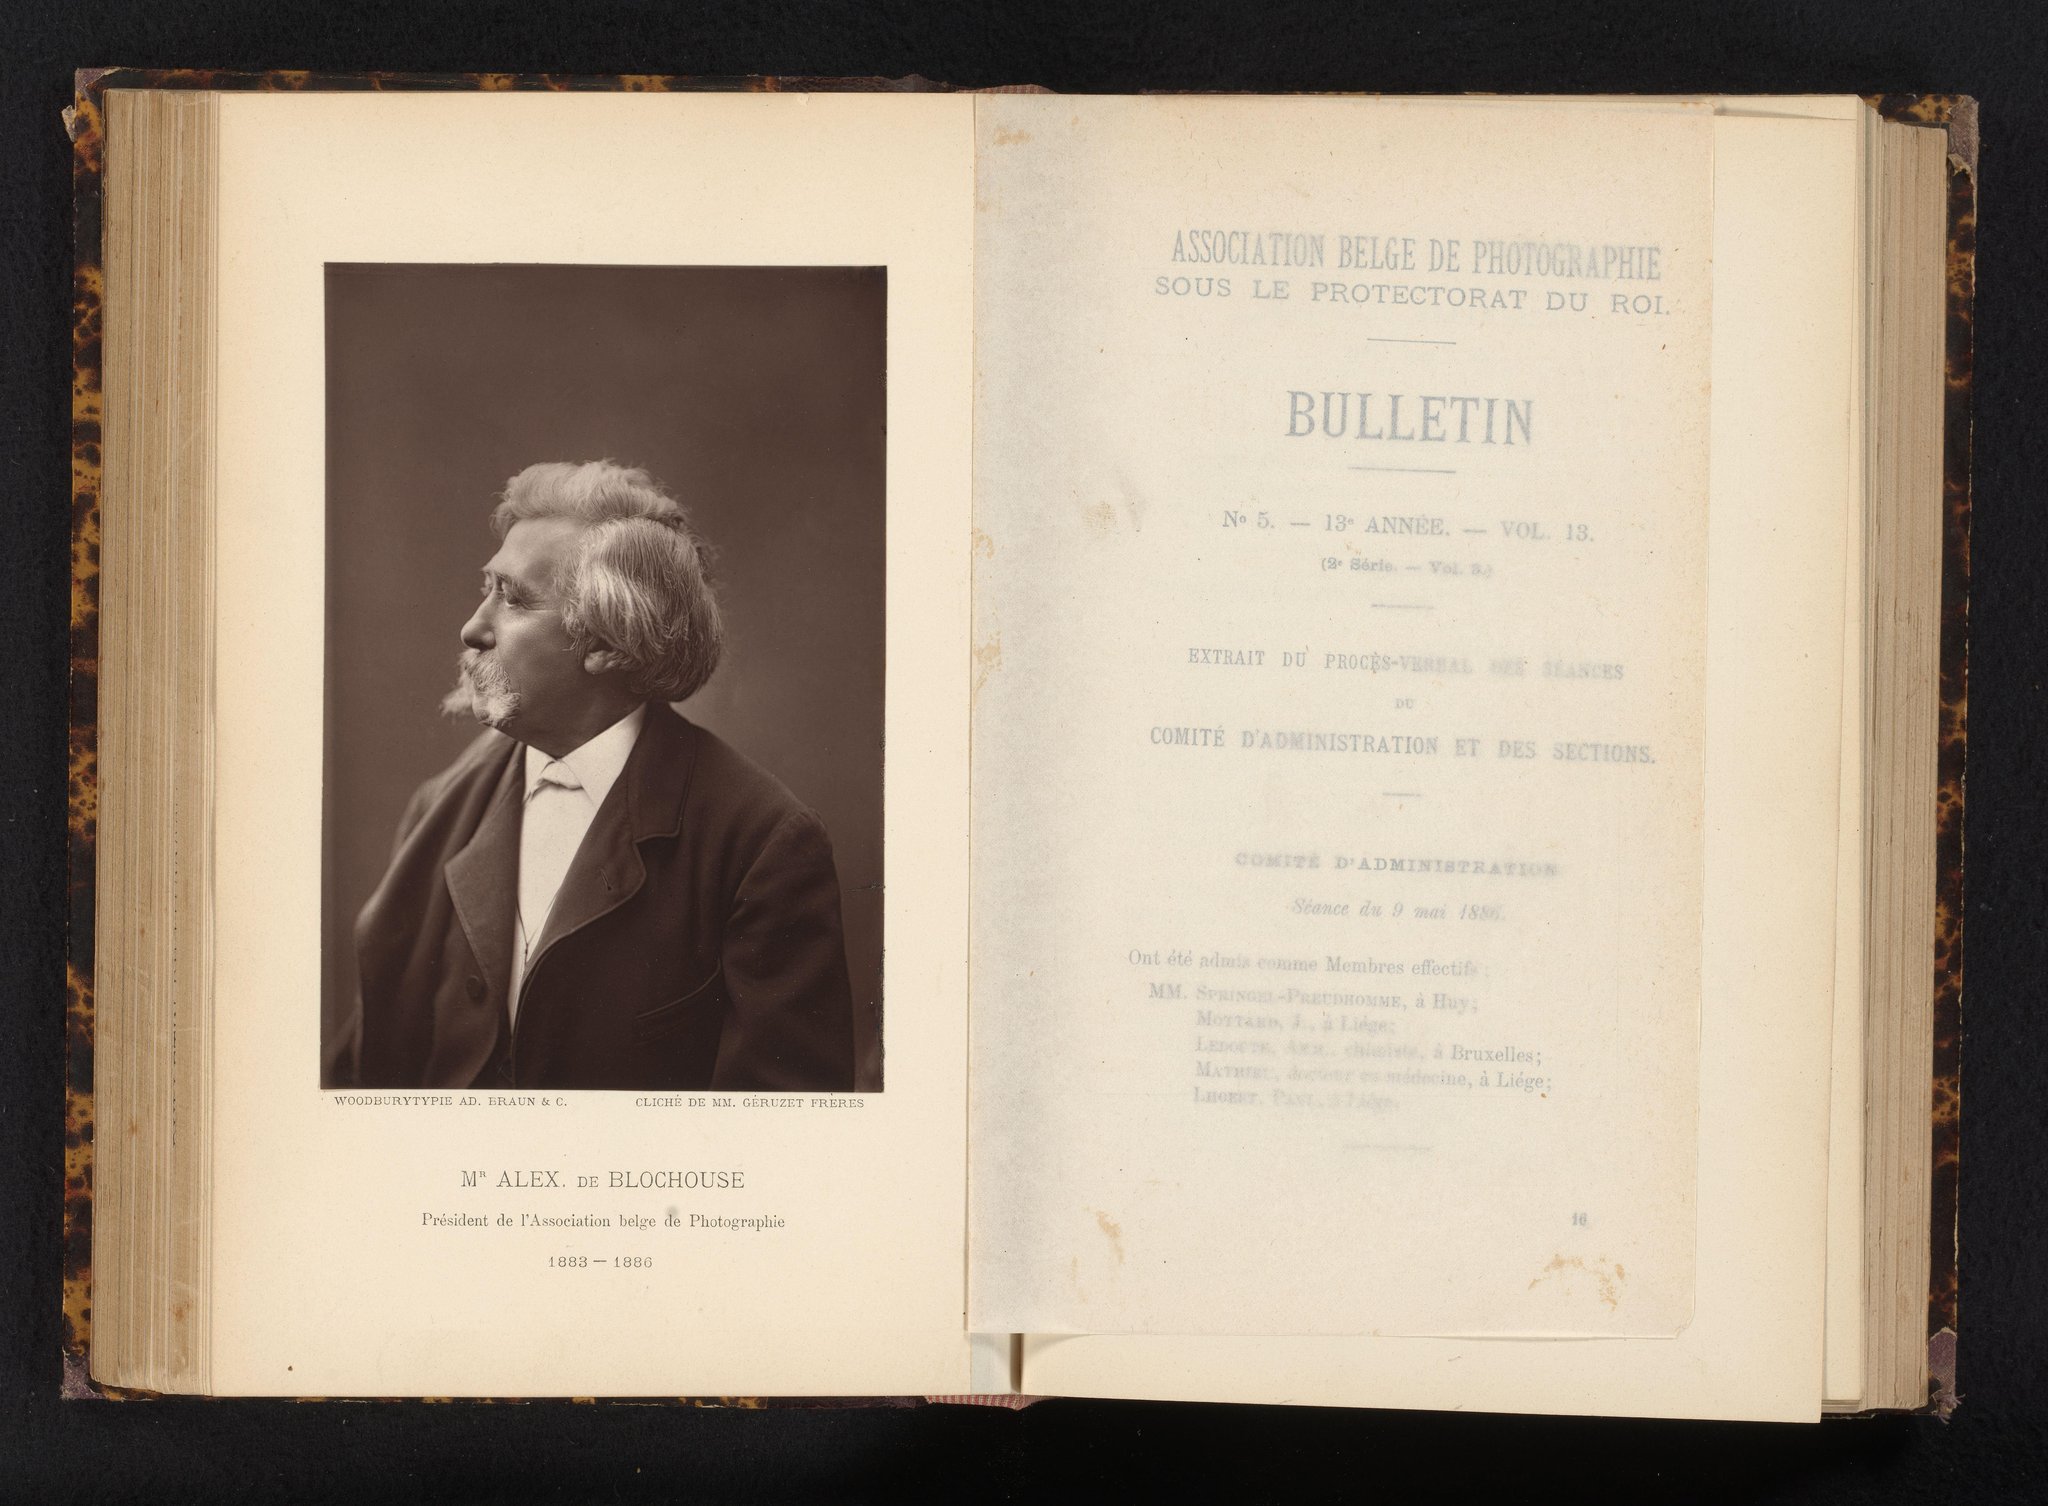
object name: photomechanical print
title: Mr Alex. de Blochouse, Président de l'Association belge de Photographie 1883-1886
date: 1883-1886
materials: paper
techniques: woodburytype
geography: dornach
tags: brussels, alexandre de blochouse, chairman, adult man, historical persons